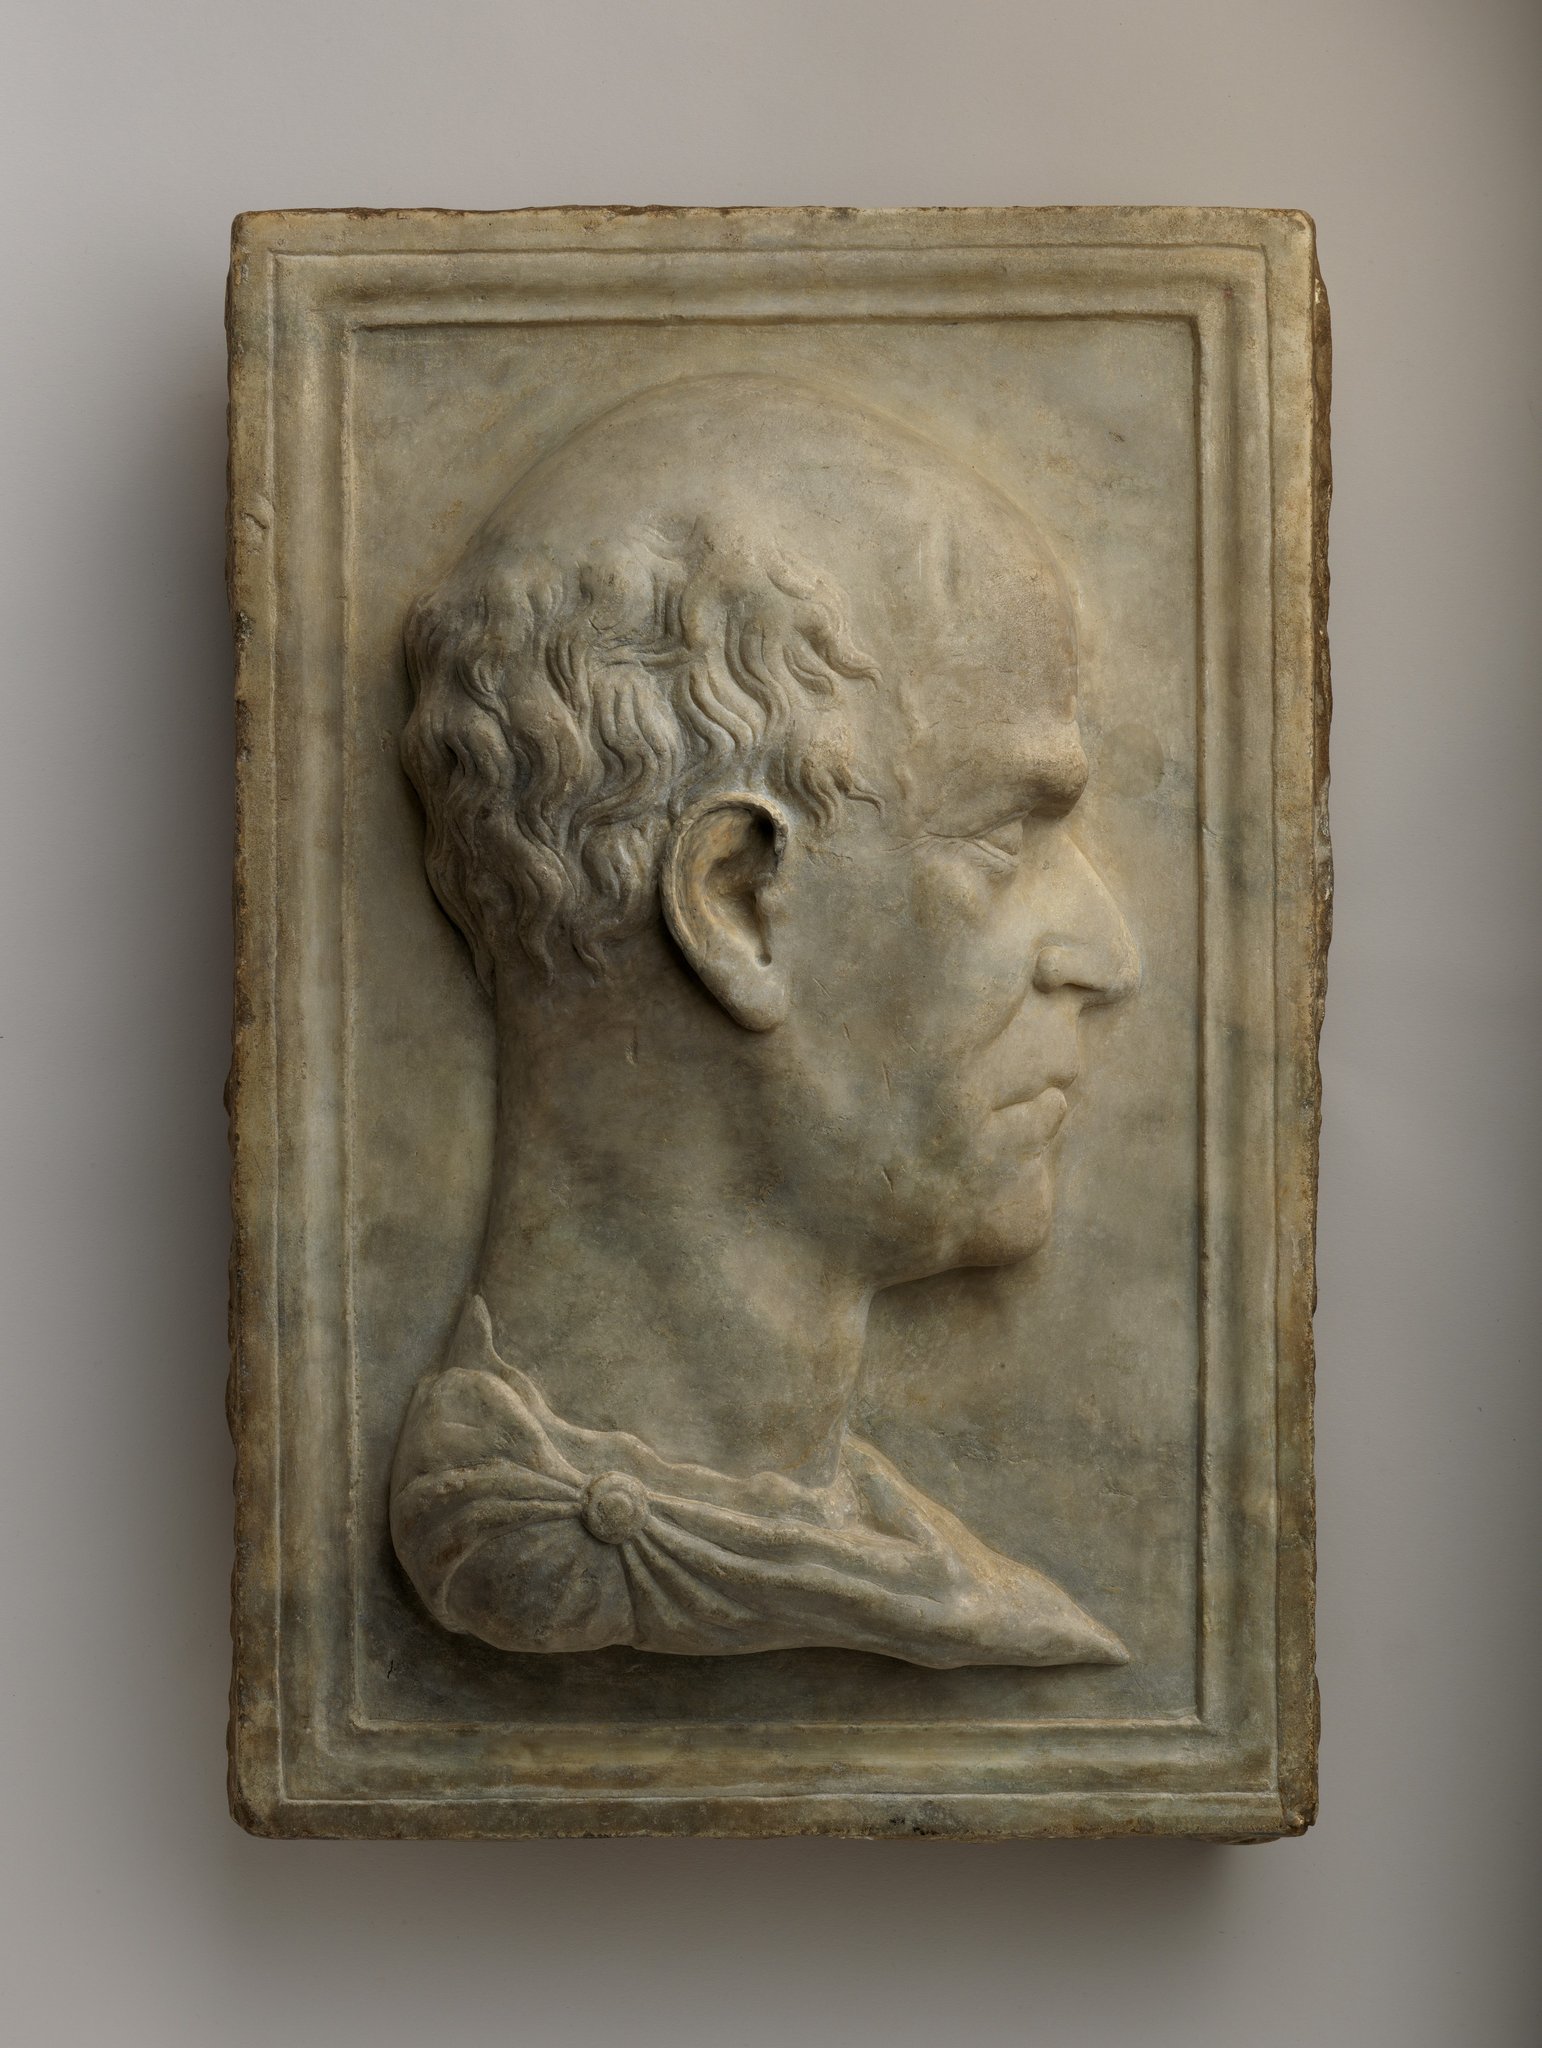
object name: relief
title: Giovanni Gioviano Pontano (1426–1503)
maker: adriano fiorentino (adriano di giovanni de' maestri)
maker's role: artist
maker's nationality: italian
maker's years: 1450-1499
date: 1490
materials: marble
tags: men,profiles